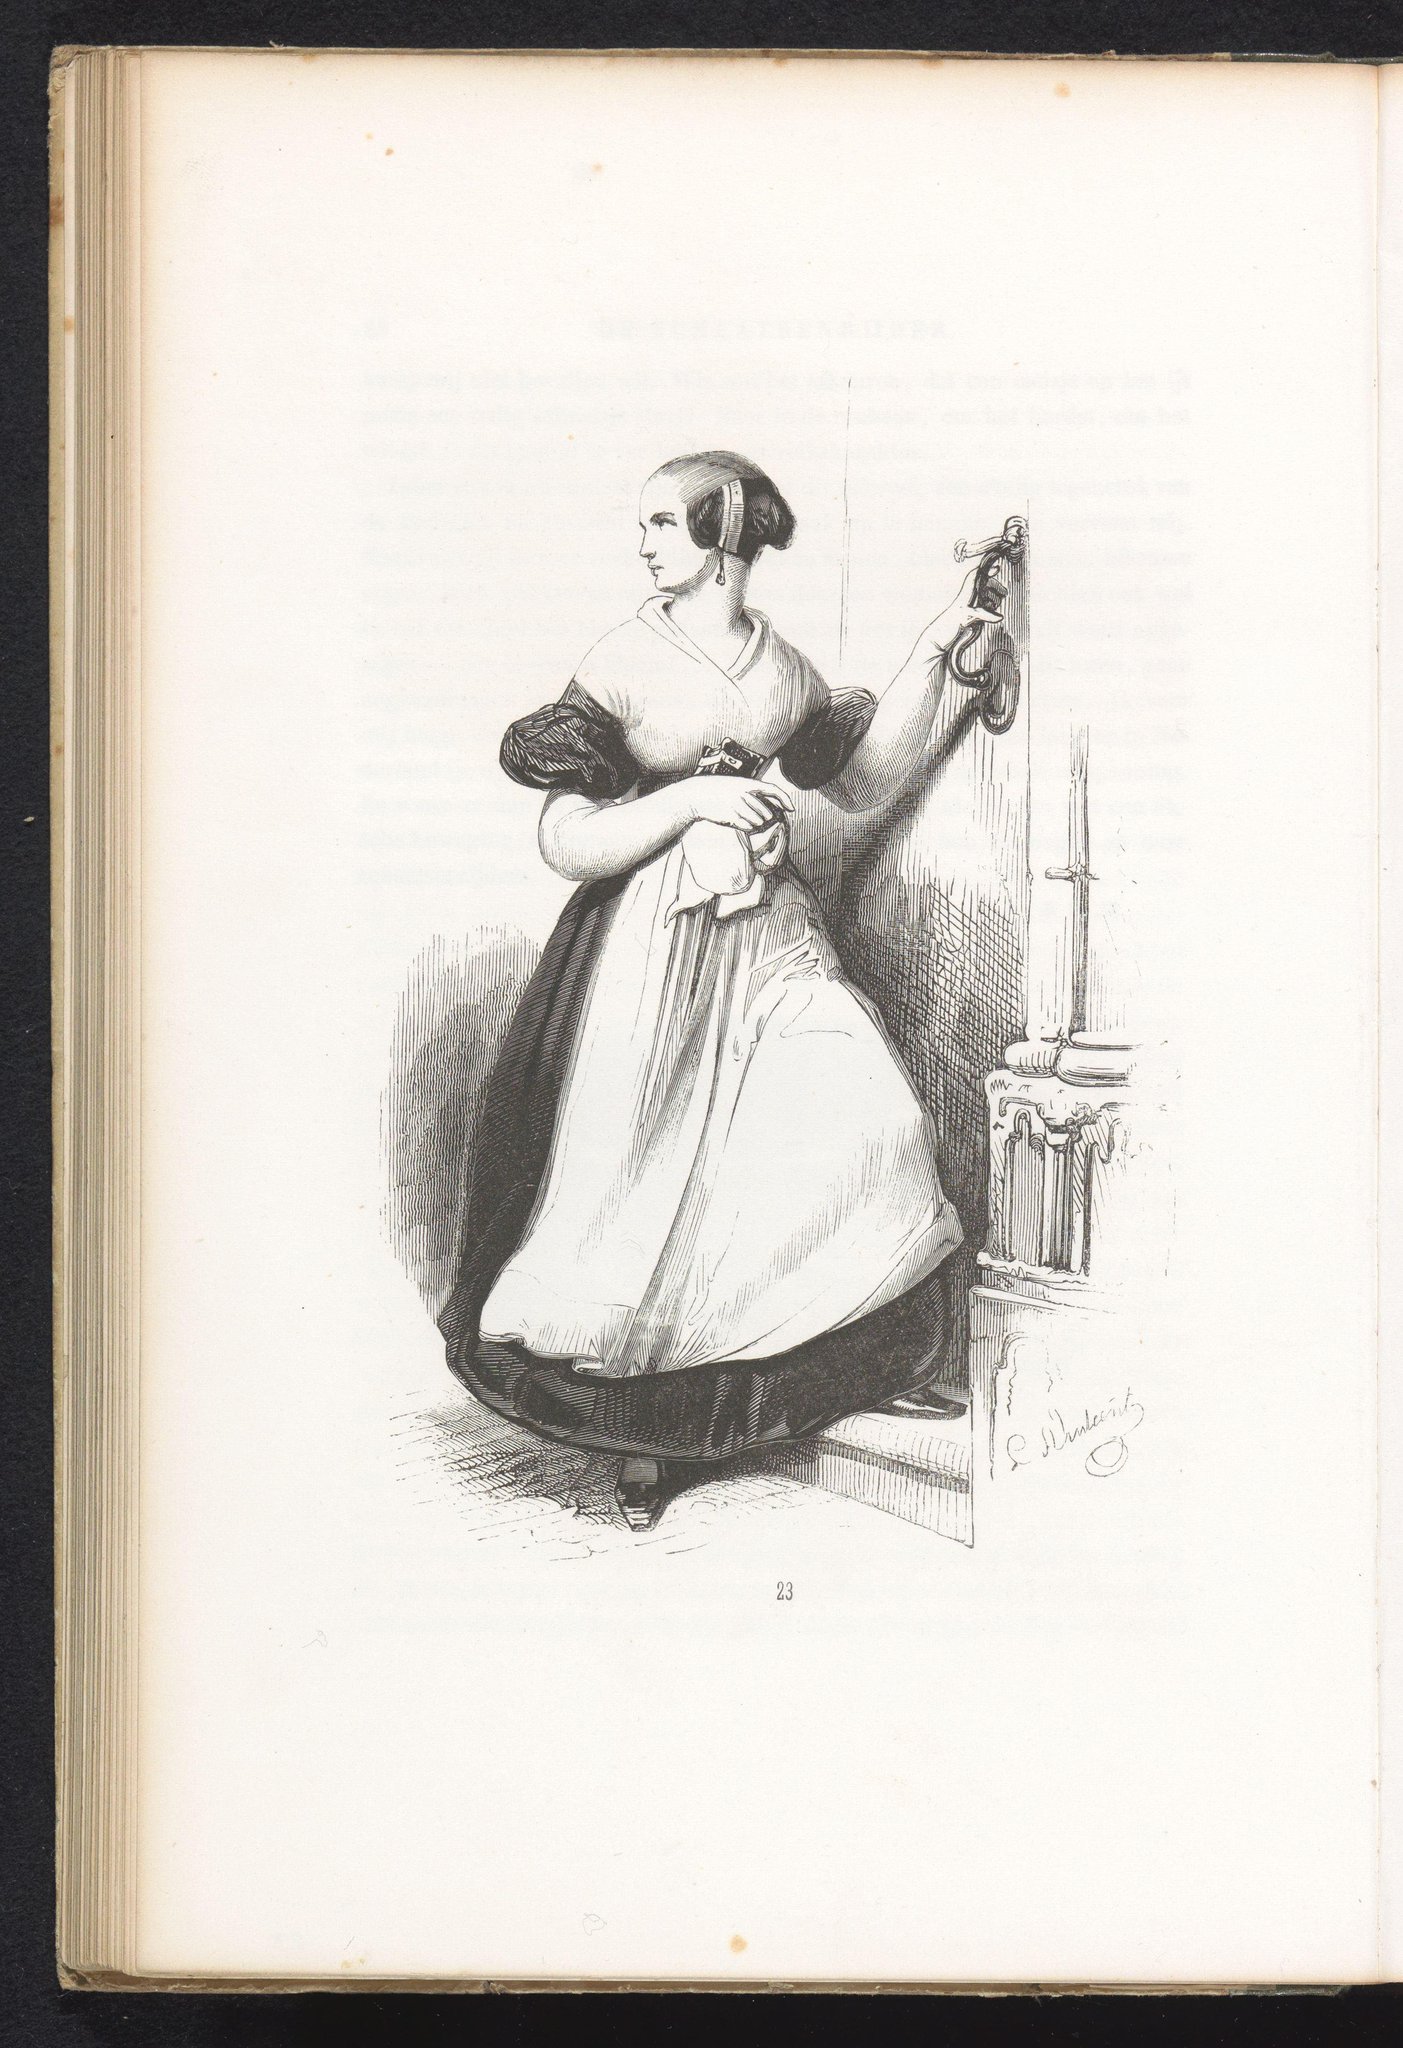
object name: print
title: Het lutherse weesmeisje van Amsterdam, 1840-1841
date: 1841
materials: paper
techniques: letterpress printing, engraving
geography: netherlands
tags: professional clothes, orphanage, orphans, amsterdam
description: Het lutherse weesmeisje van Amsterdam. Een meisje klopt aan bij een deur. Genummerd: 23. Illustratie in het boek 'De Nederlanden: karakterschetsen, kleederdrachten, houding en voorkomen van verschillende standen', een boek met karakterschetsen, beroepen en klederdrachten van Nederlandse volkstypen uit 1841.